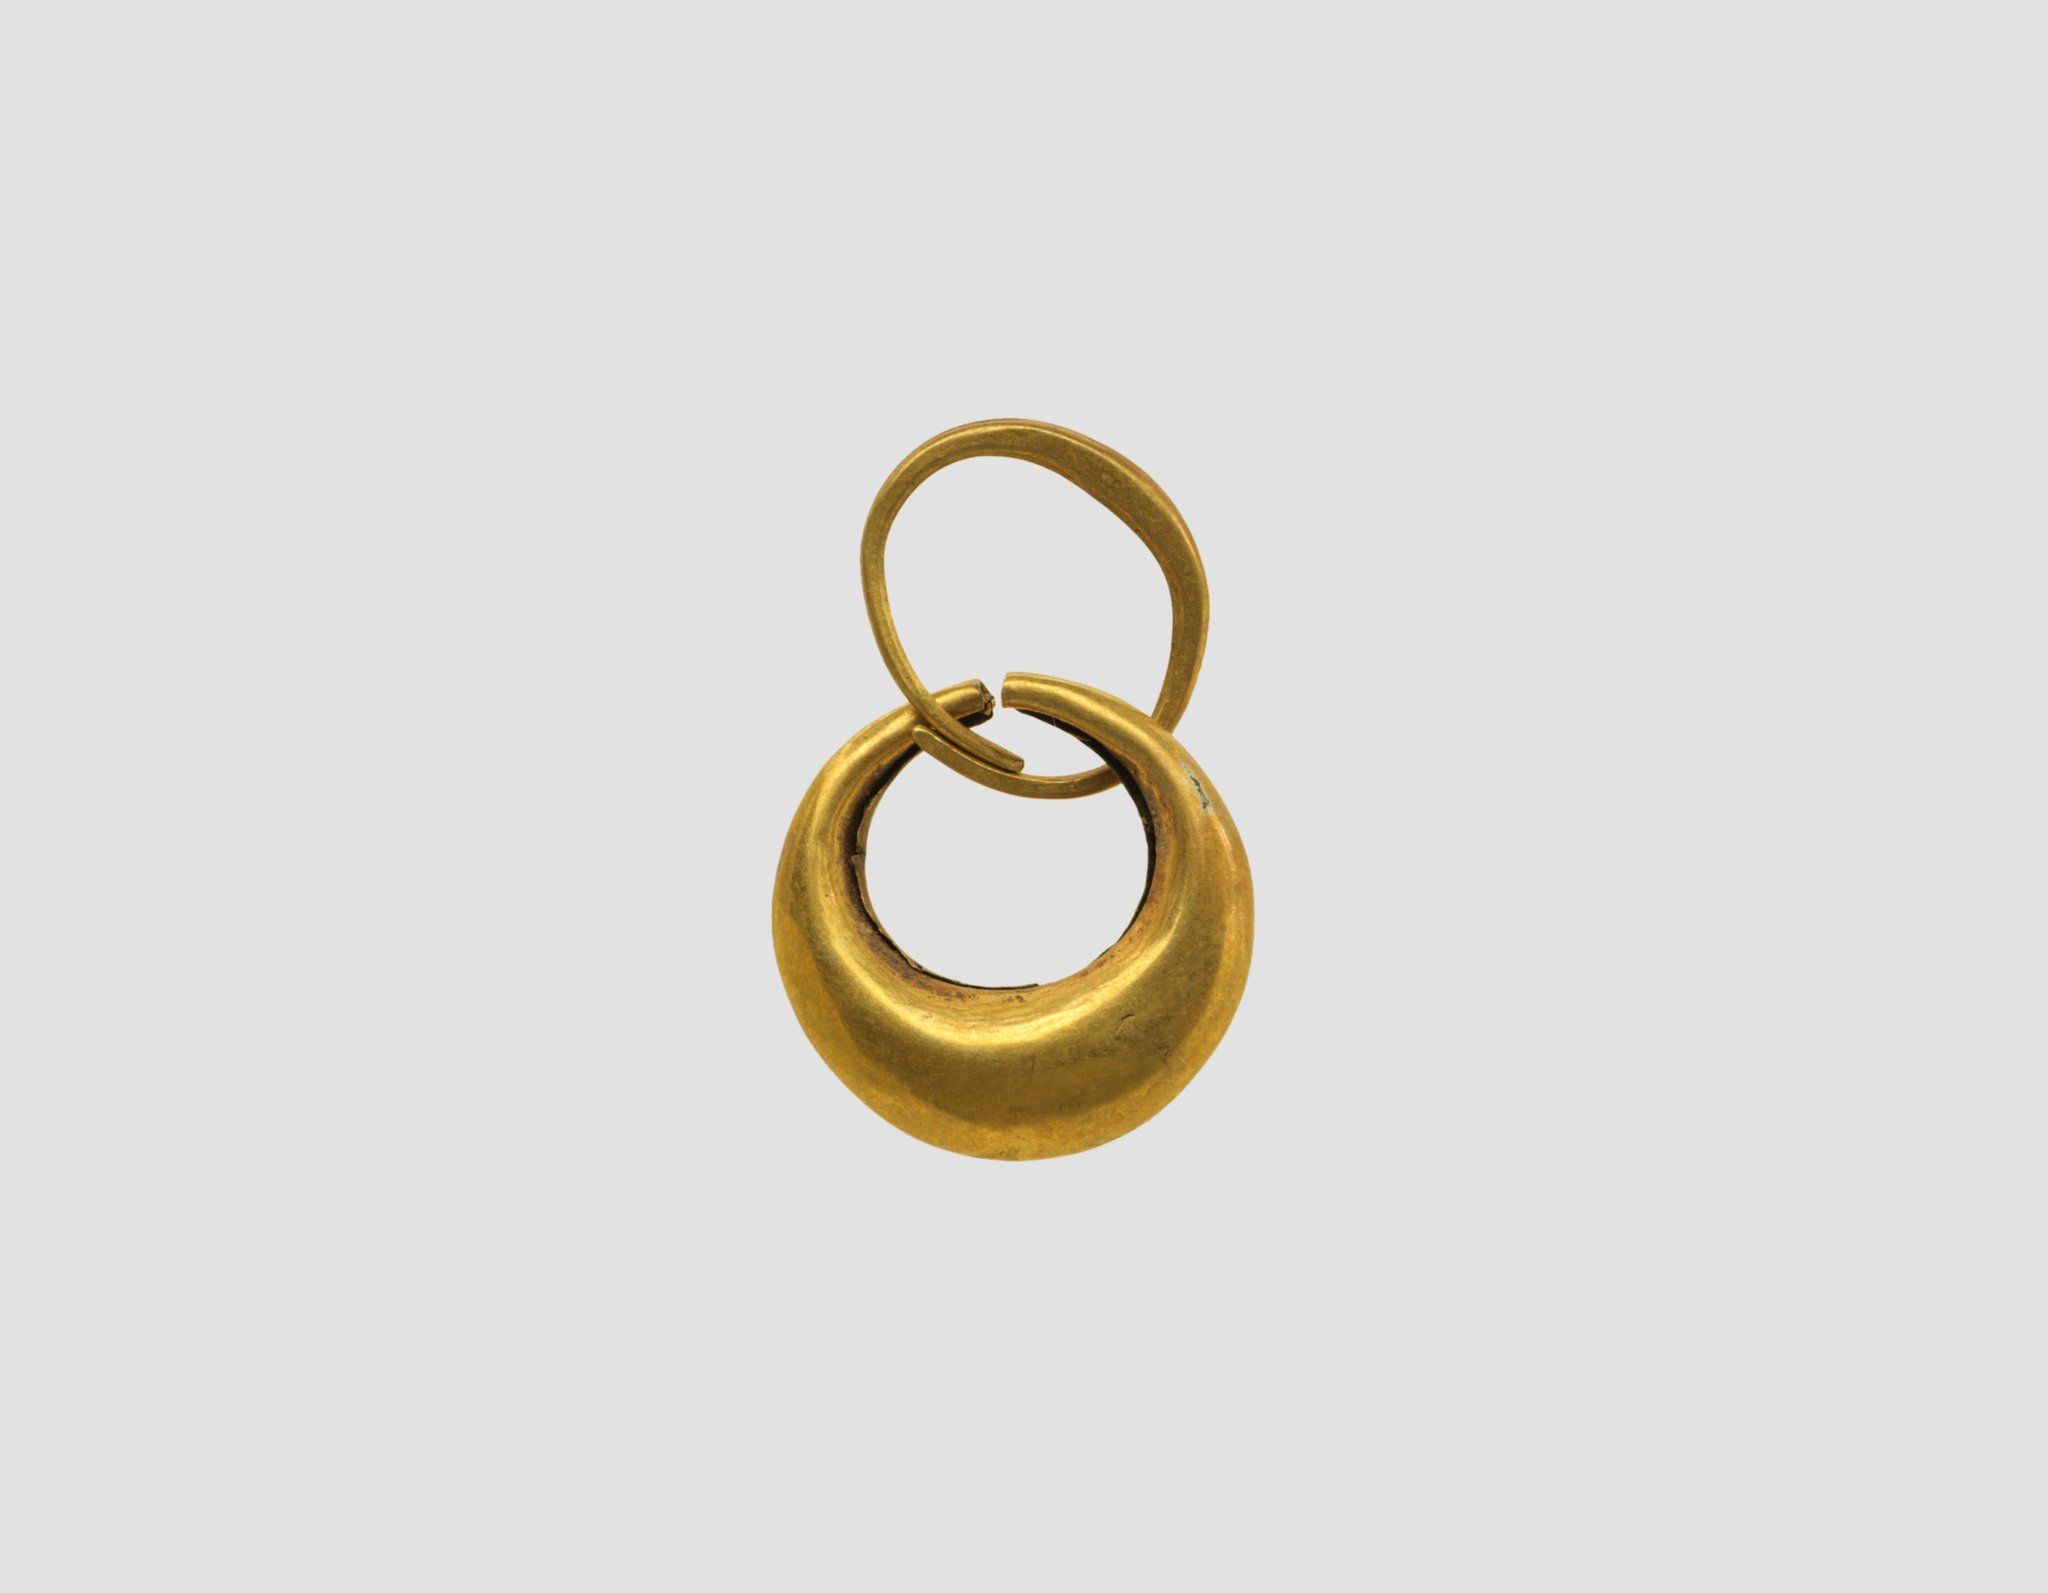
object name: earring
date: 700-301 BCE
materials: gold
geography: mesopotamia